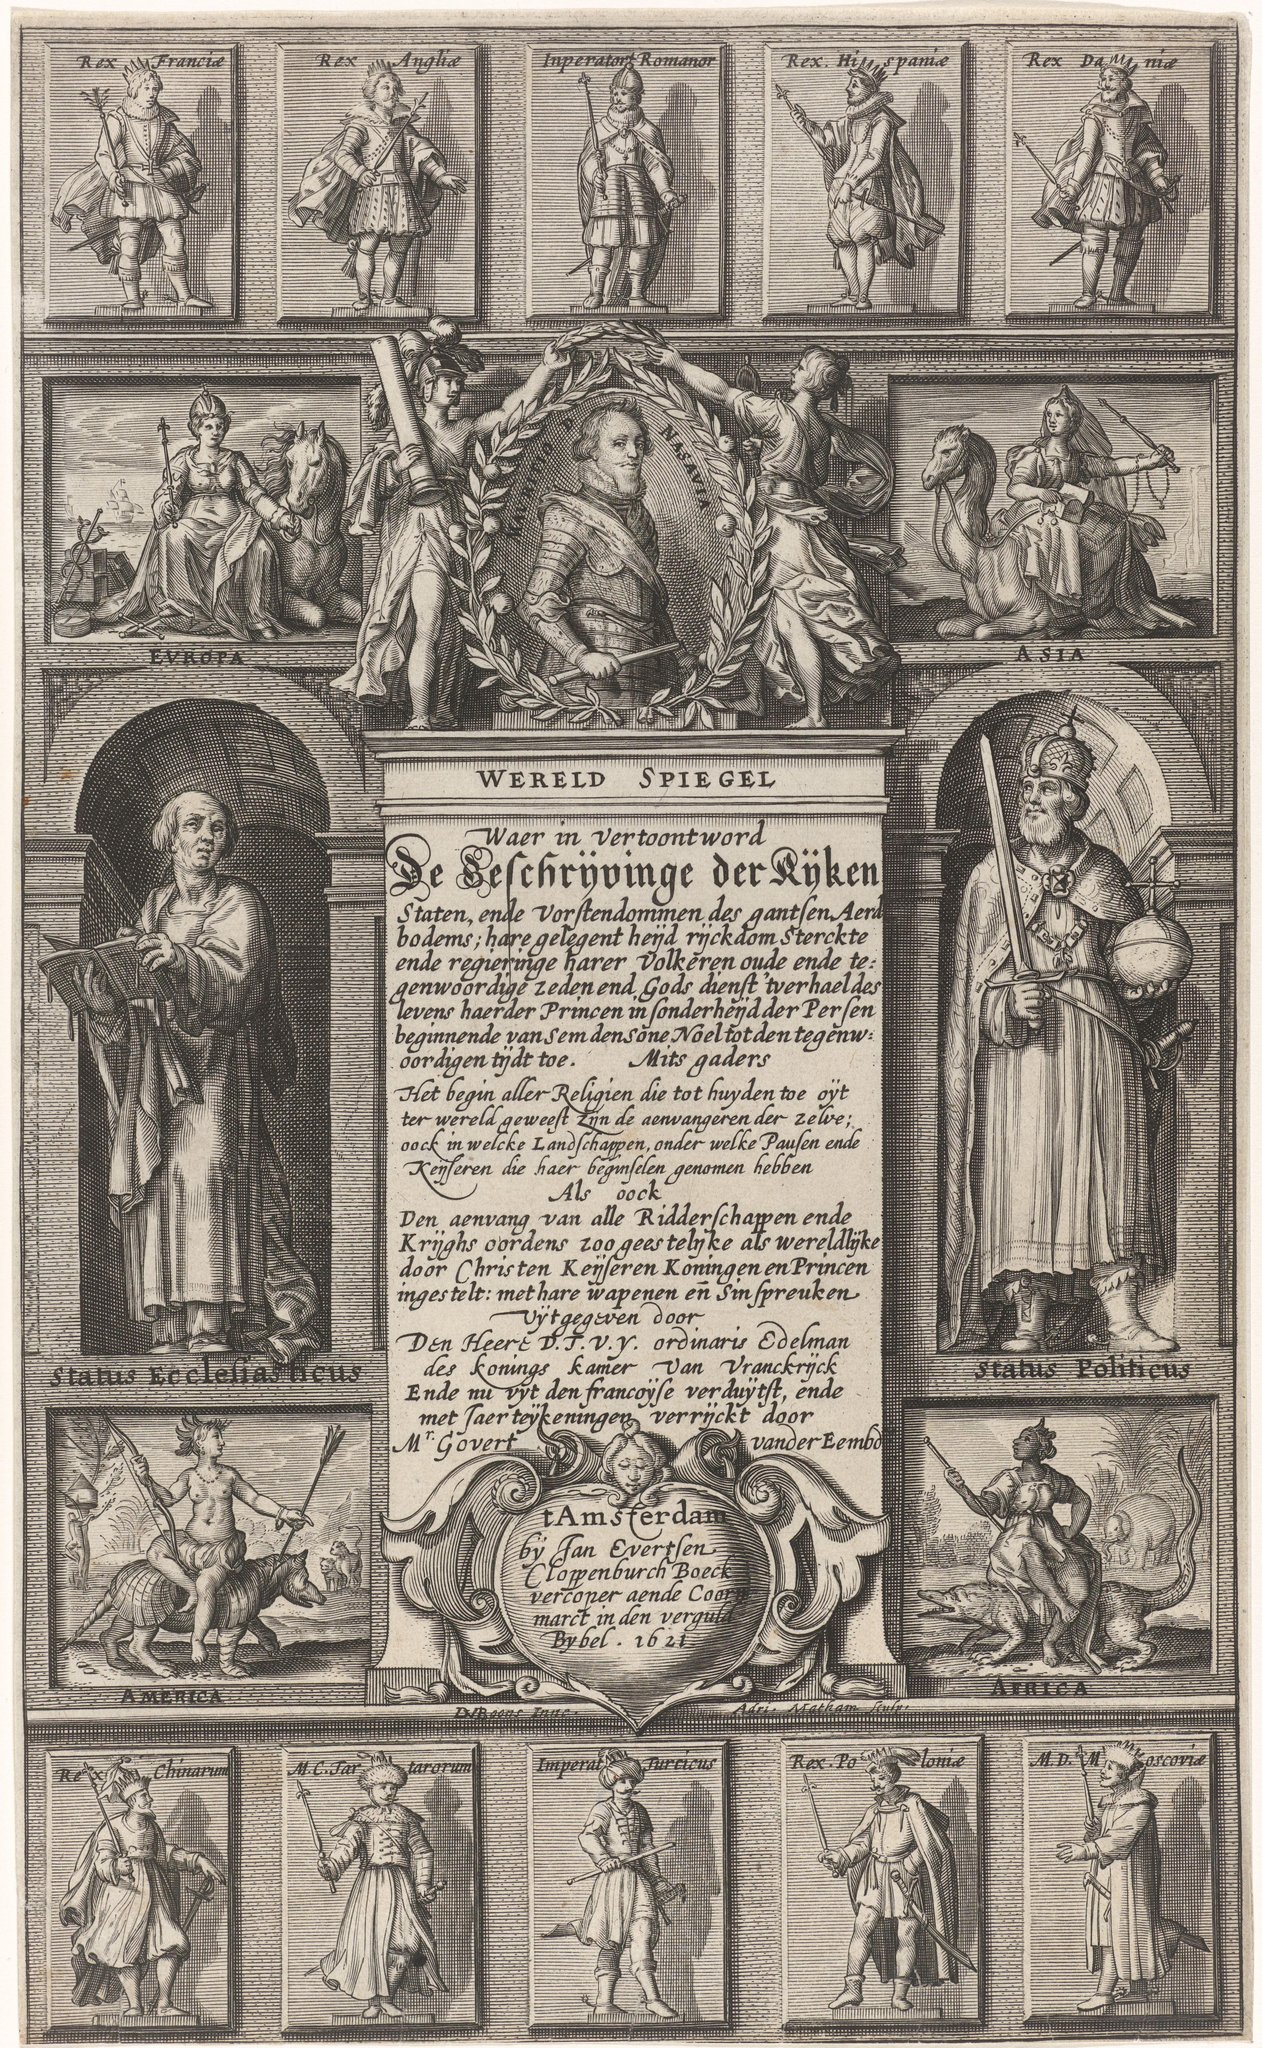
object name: titelblad, titelpagina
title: Titelpagina voor: Pierre d'Avity, Wereld spiegel, 1621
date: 1621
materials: paper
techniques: engraving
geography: amsterdam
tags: the hague, maurice (prince of orange), the church symbolized, emperor, government, the state; 'politica', 'auttorità o potestà' (ripa), ruler, sovereign, continents represented allegorically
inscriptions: collector's mark: Lugt 2228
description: Een met lauwerkrans omgeven portret van Maurits, prins van Oranje geflankeerd door twee vrouwelijke personificaties. Links in een nis de personificatie van de kerk, rechts die van de politiek, in keizerlijke kleren met zwaard en rijksappel. Daaromheen vier personificaties van Europa, Azië, Amerika en Afrika. Bovenaan en onderaan een rij met vijf afbeeldingen van koningen en keizers. Titelpagina voor Pierre d'Avity, Wereld spiegel, 1621.